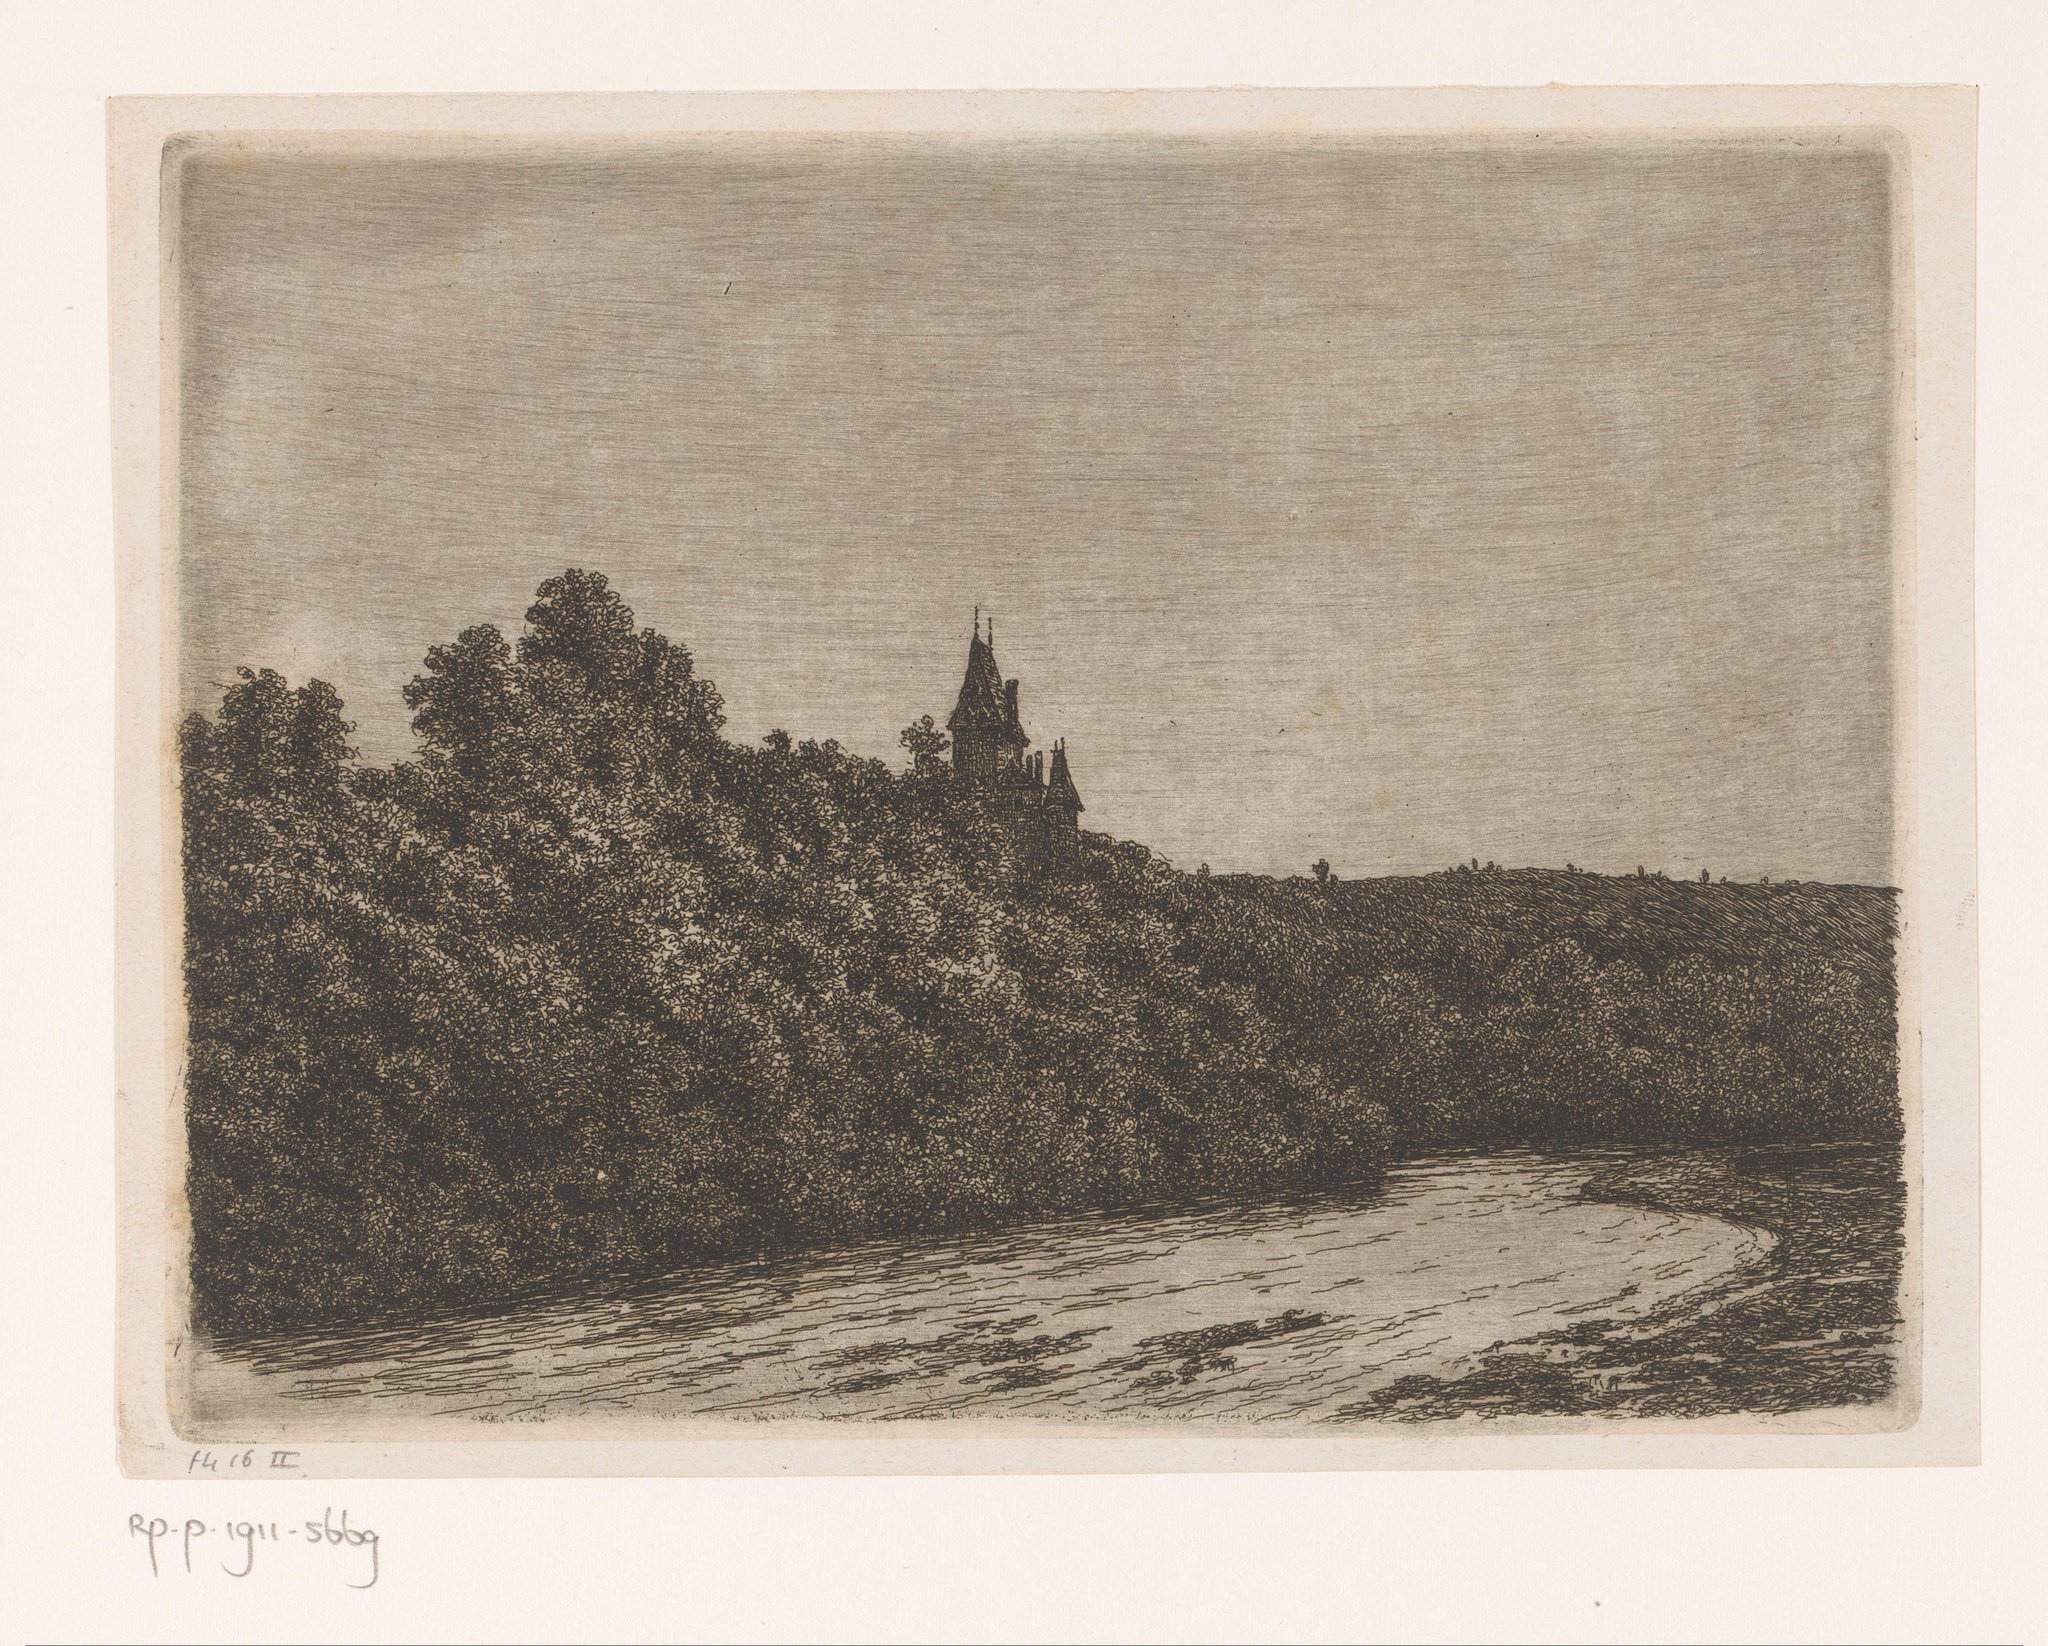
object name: print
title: Gezicht op een kasteel op de hoge linkeroever aan een rivier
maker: jean pierre françois lamorinière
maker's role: print maker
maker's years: 1828-1911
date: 1838-1911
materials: paper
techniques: etching, intaglio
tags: castle, river, landscape with tower or castle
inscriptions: collector's mark: Lugt 1485, collector's mark: Lugt 2228